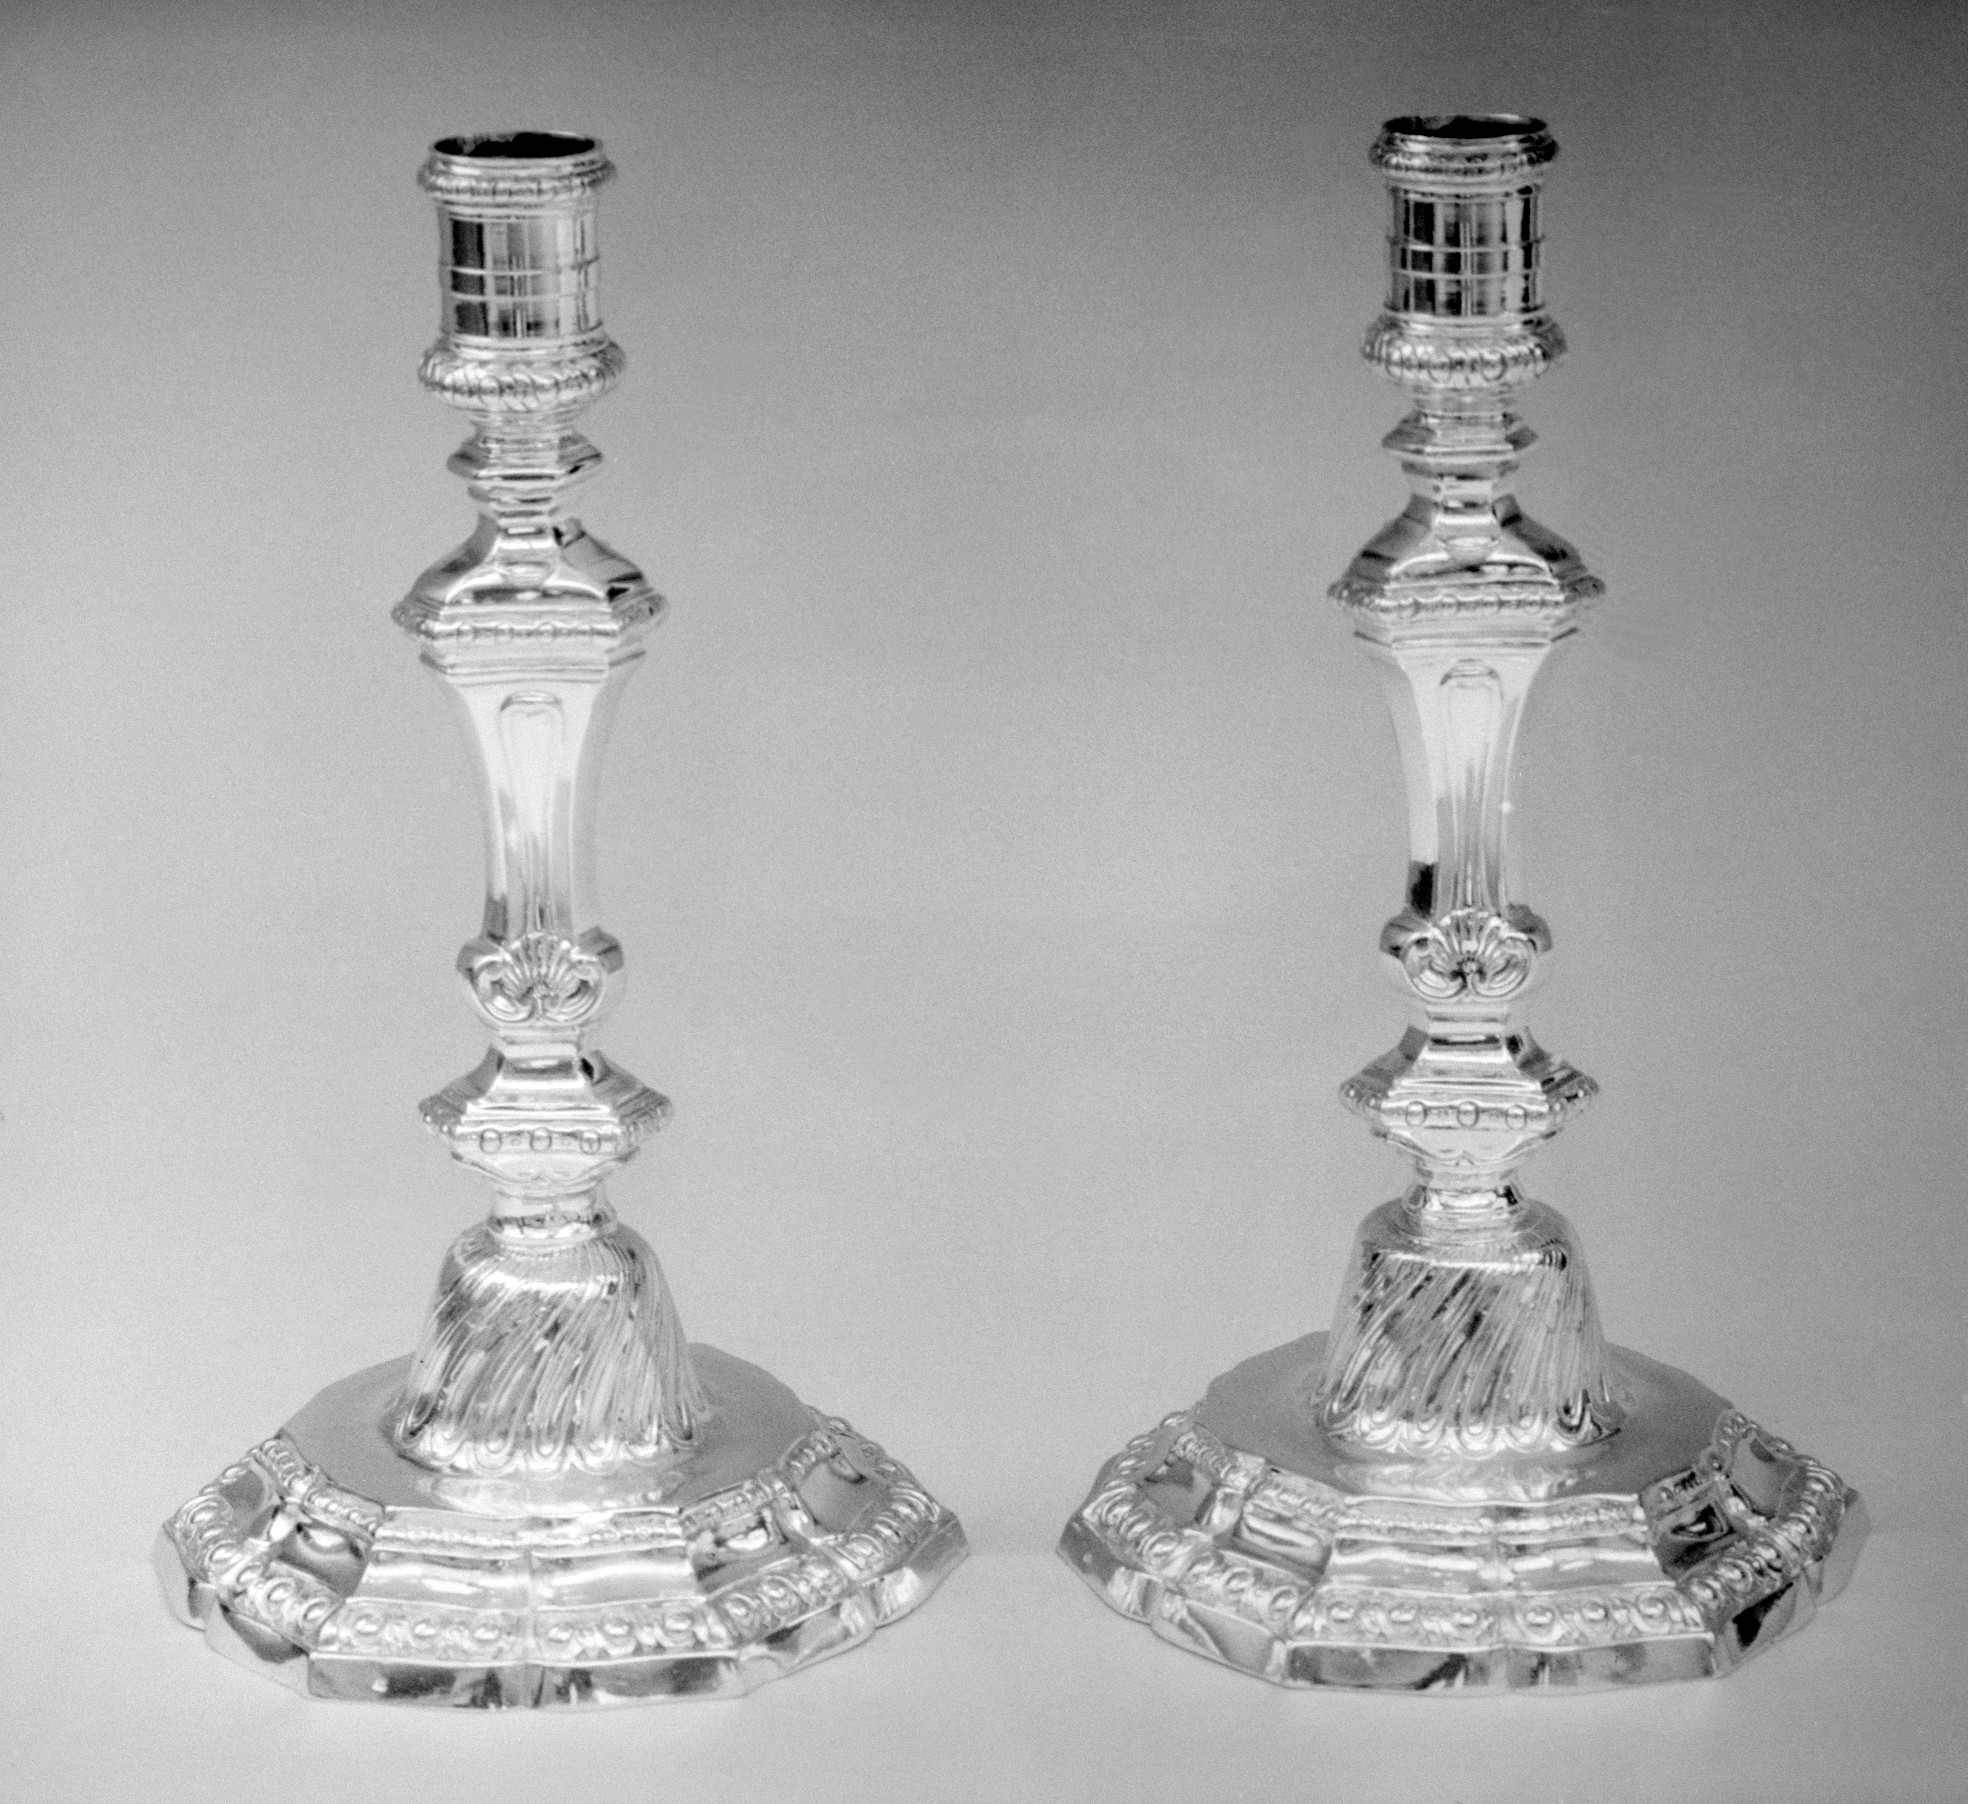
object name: candlestick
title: Pair of candlesticks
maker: jean-françois balzac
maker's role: maker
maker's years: 1711-1766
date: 1763-1764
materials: silver